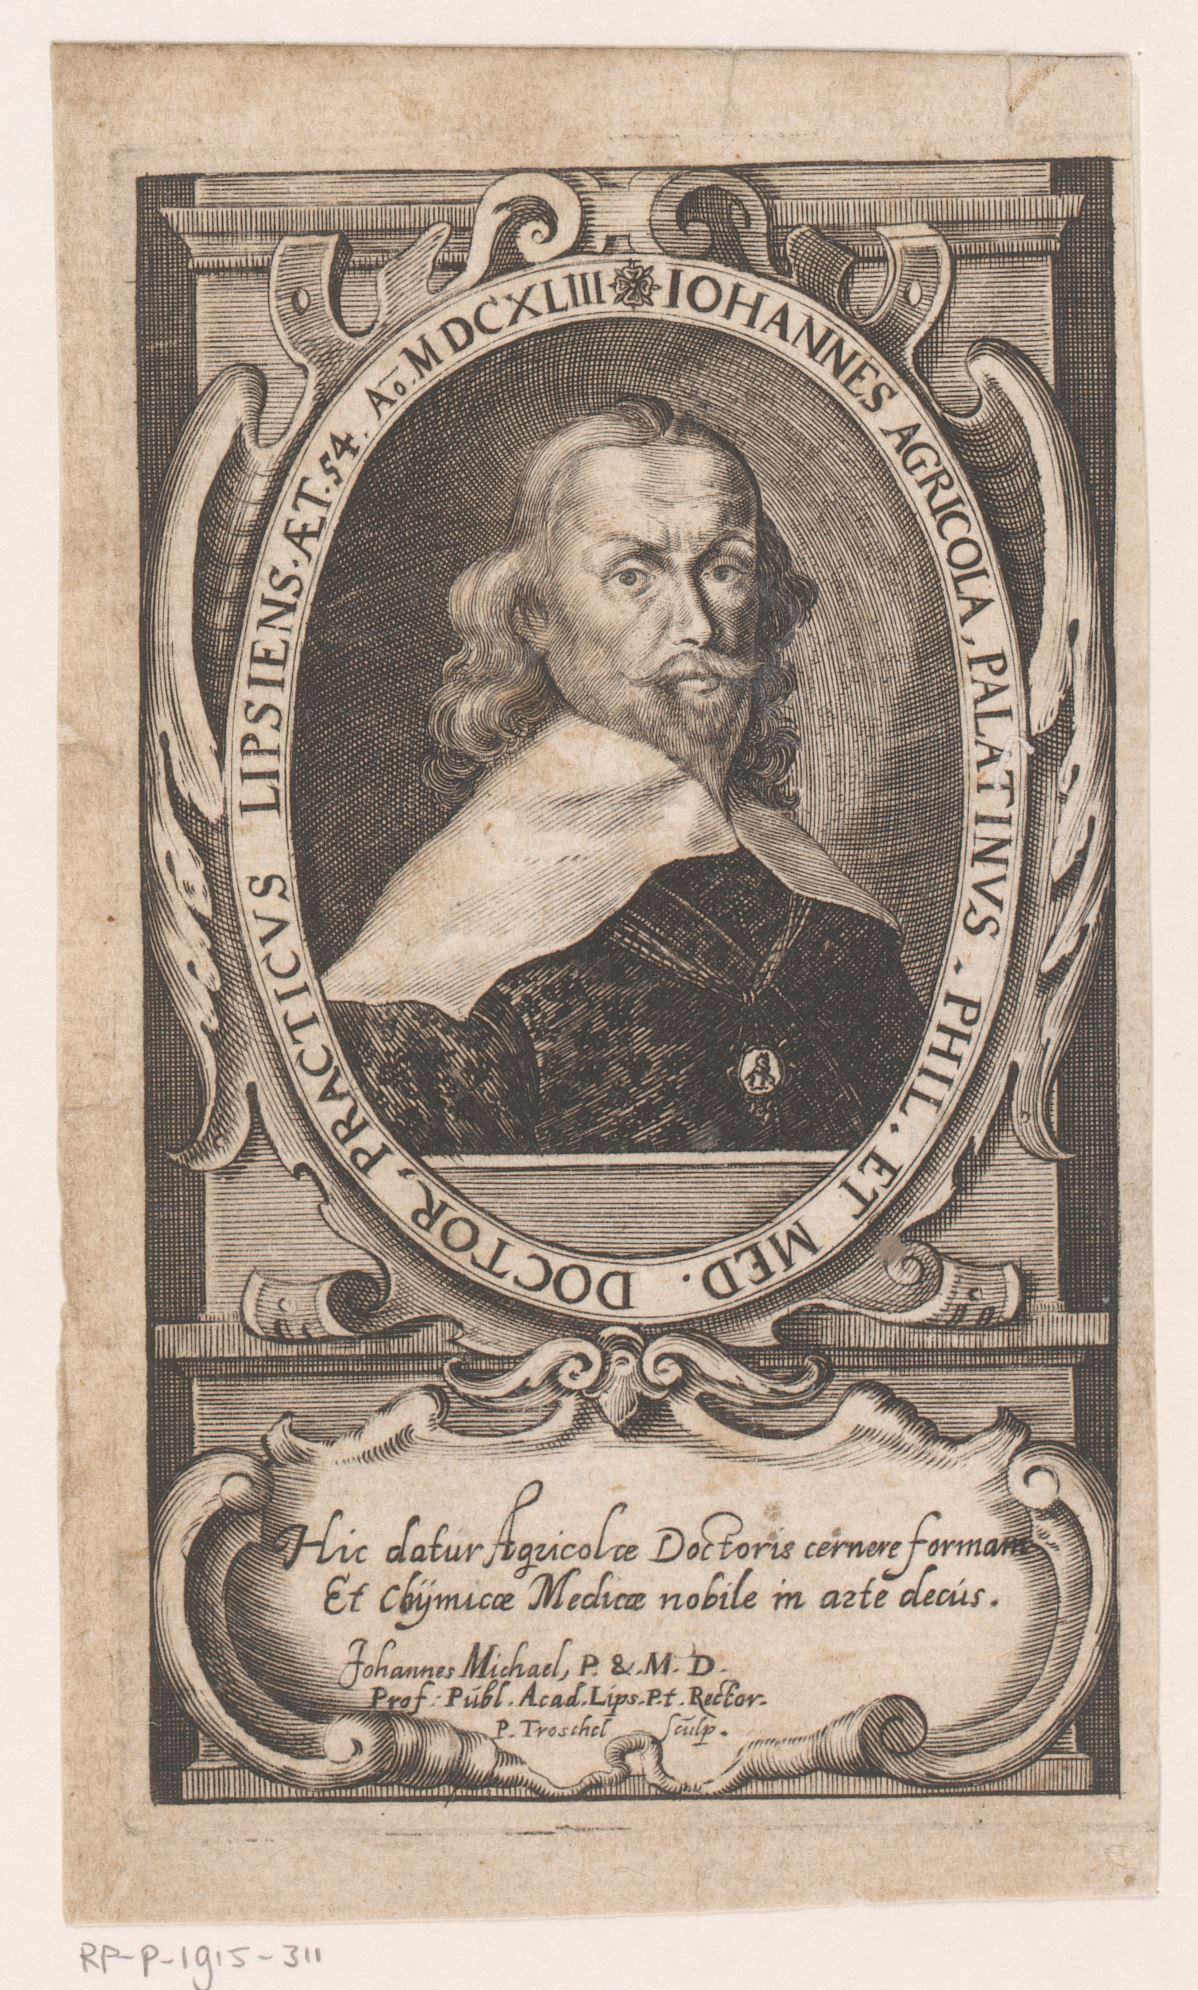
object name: print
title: Portret van Johann Agricola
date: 1659-1670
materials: paper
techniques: engraving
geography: germany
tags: historical persons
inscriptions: collector's mark: Lugt 2233